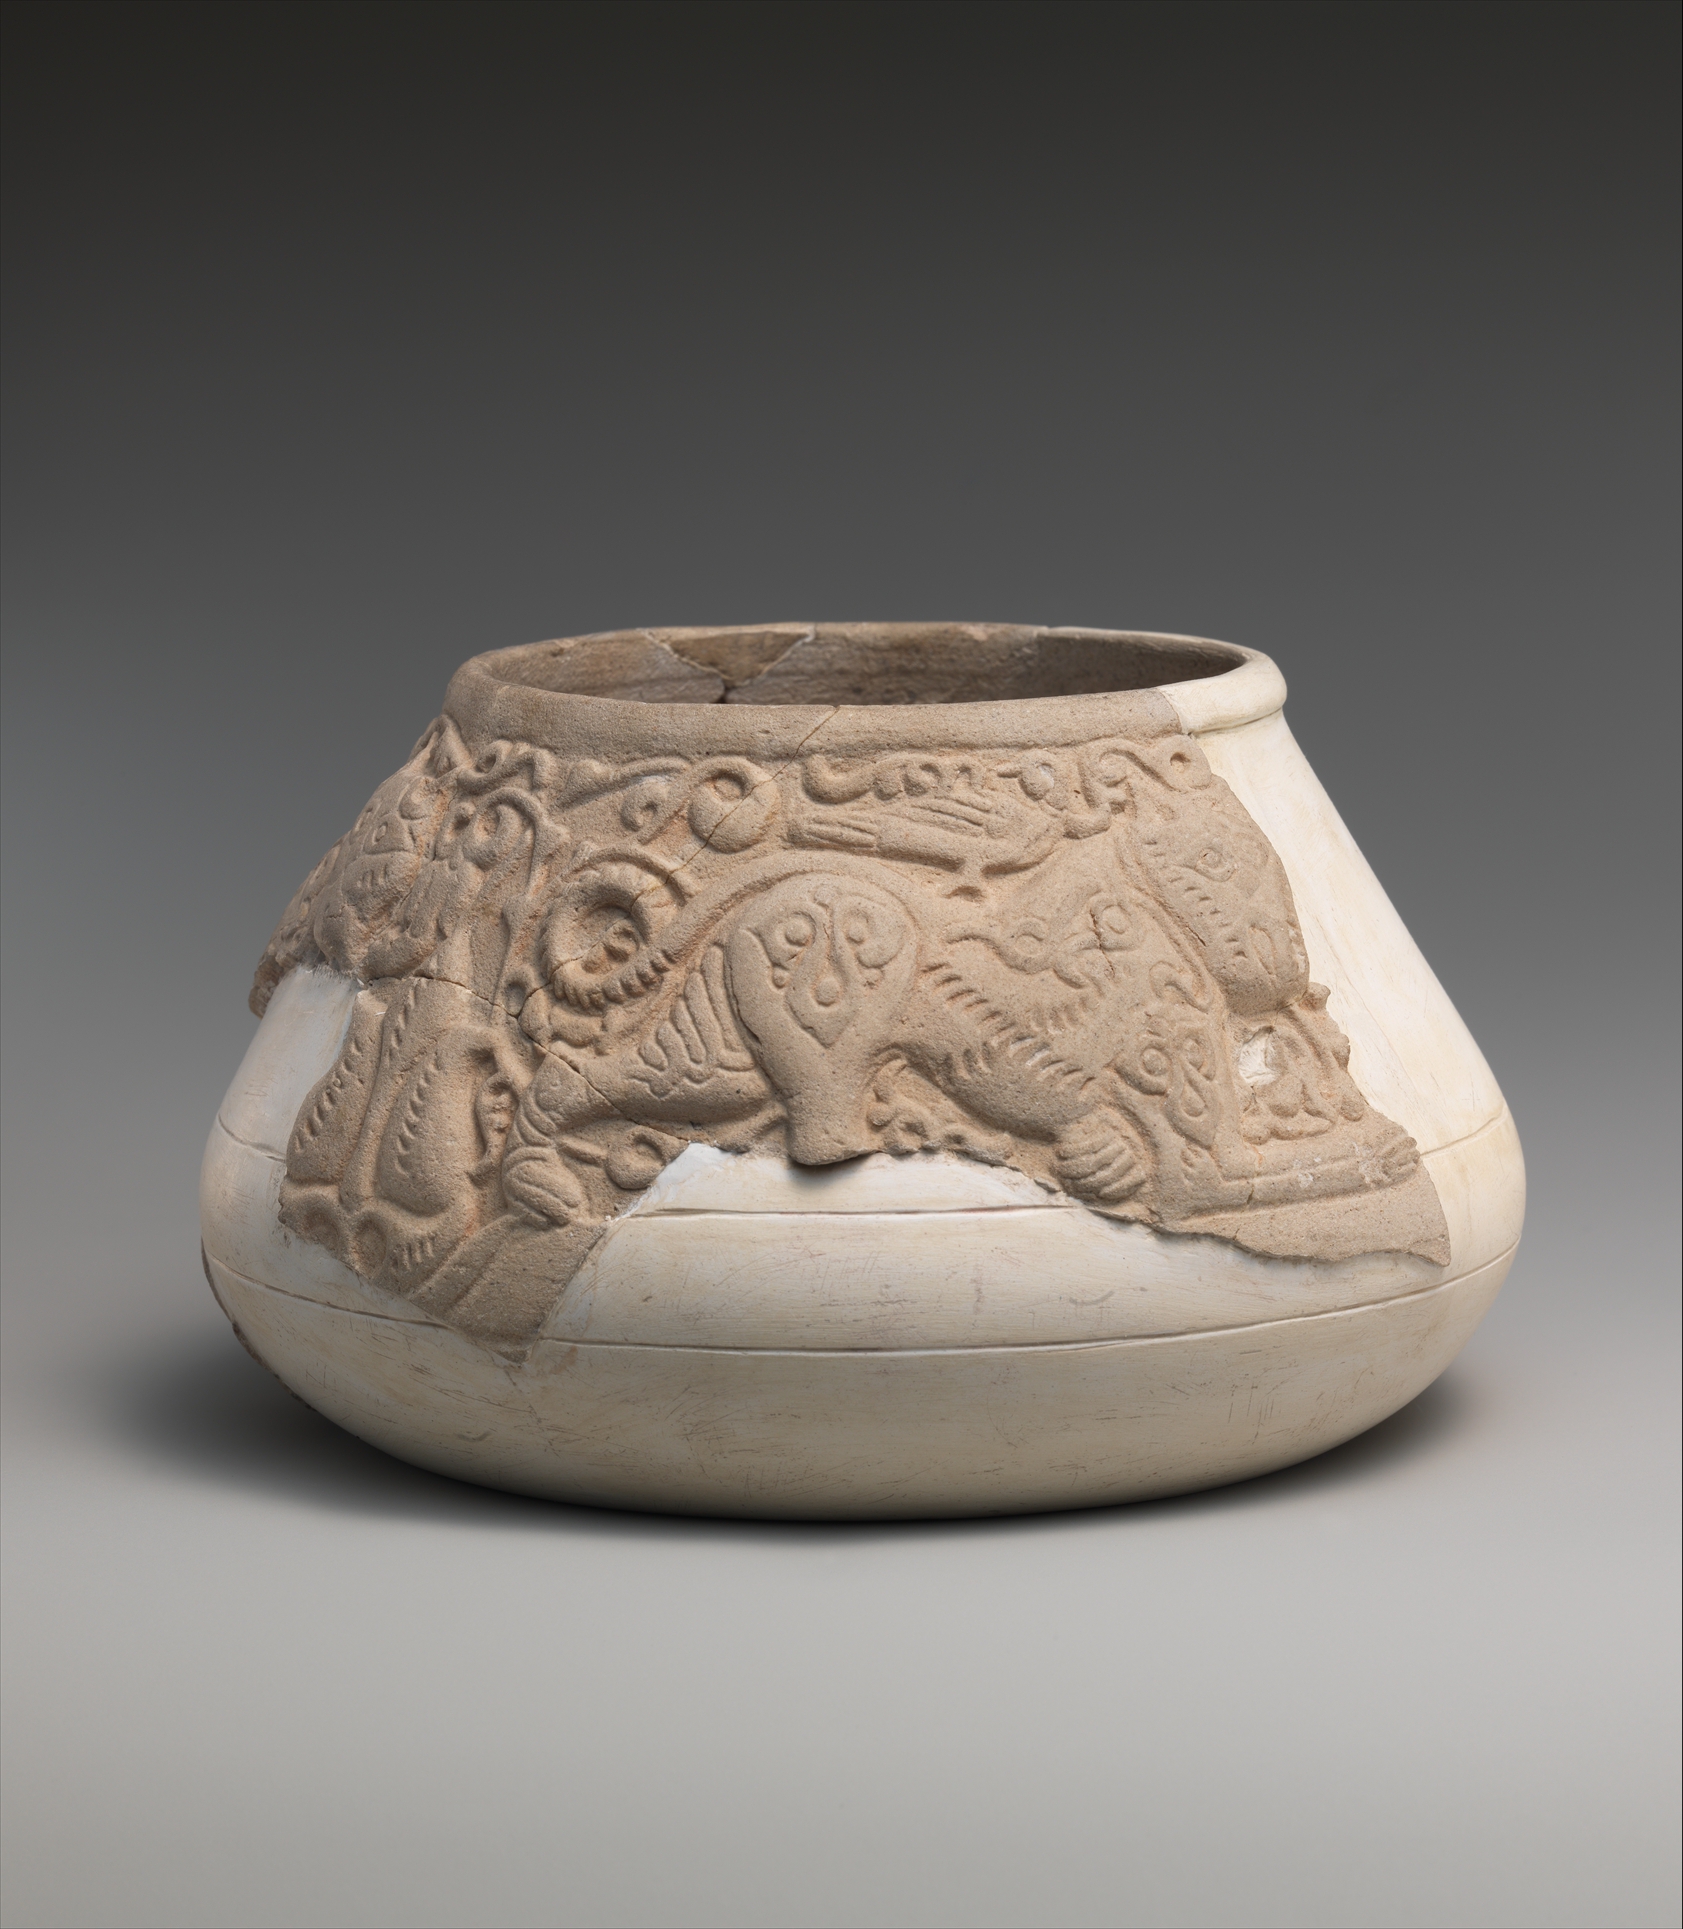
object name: master model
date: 1001-1100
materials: earthenware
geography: iran